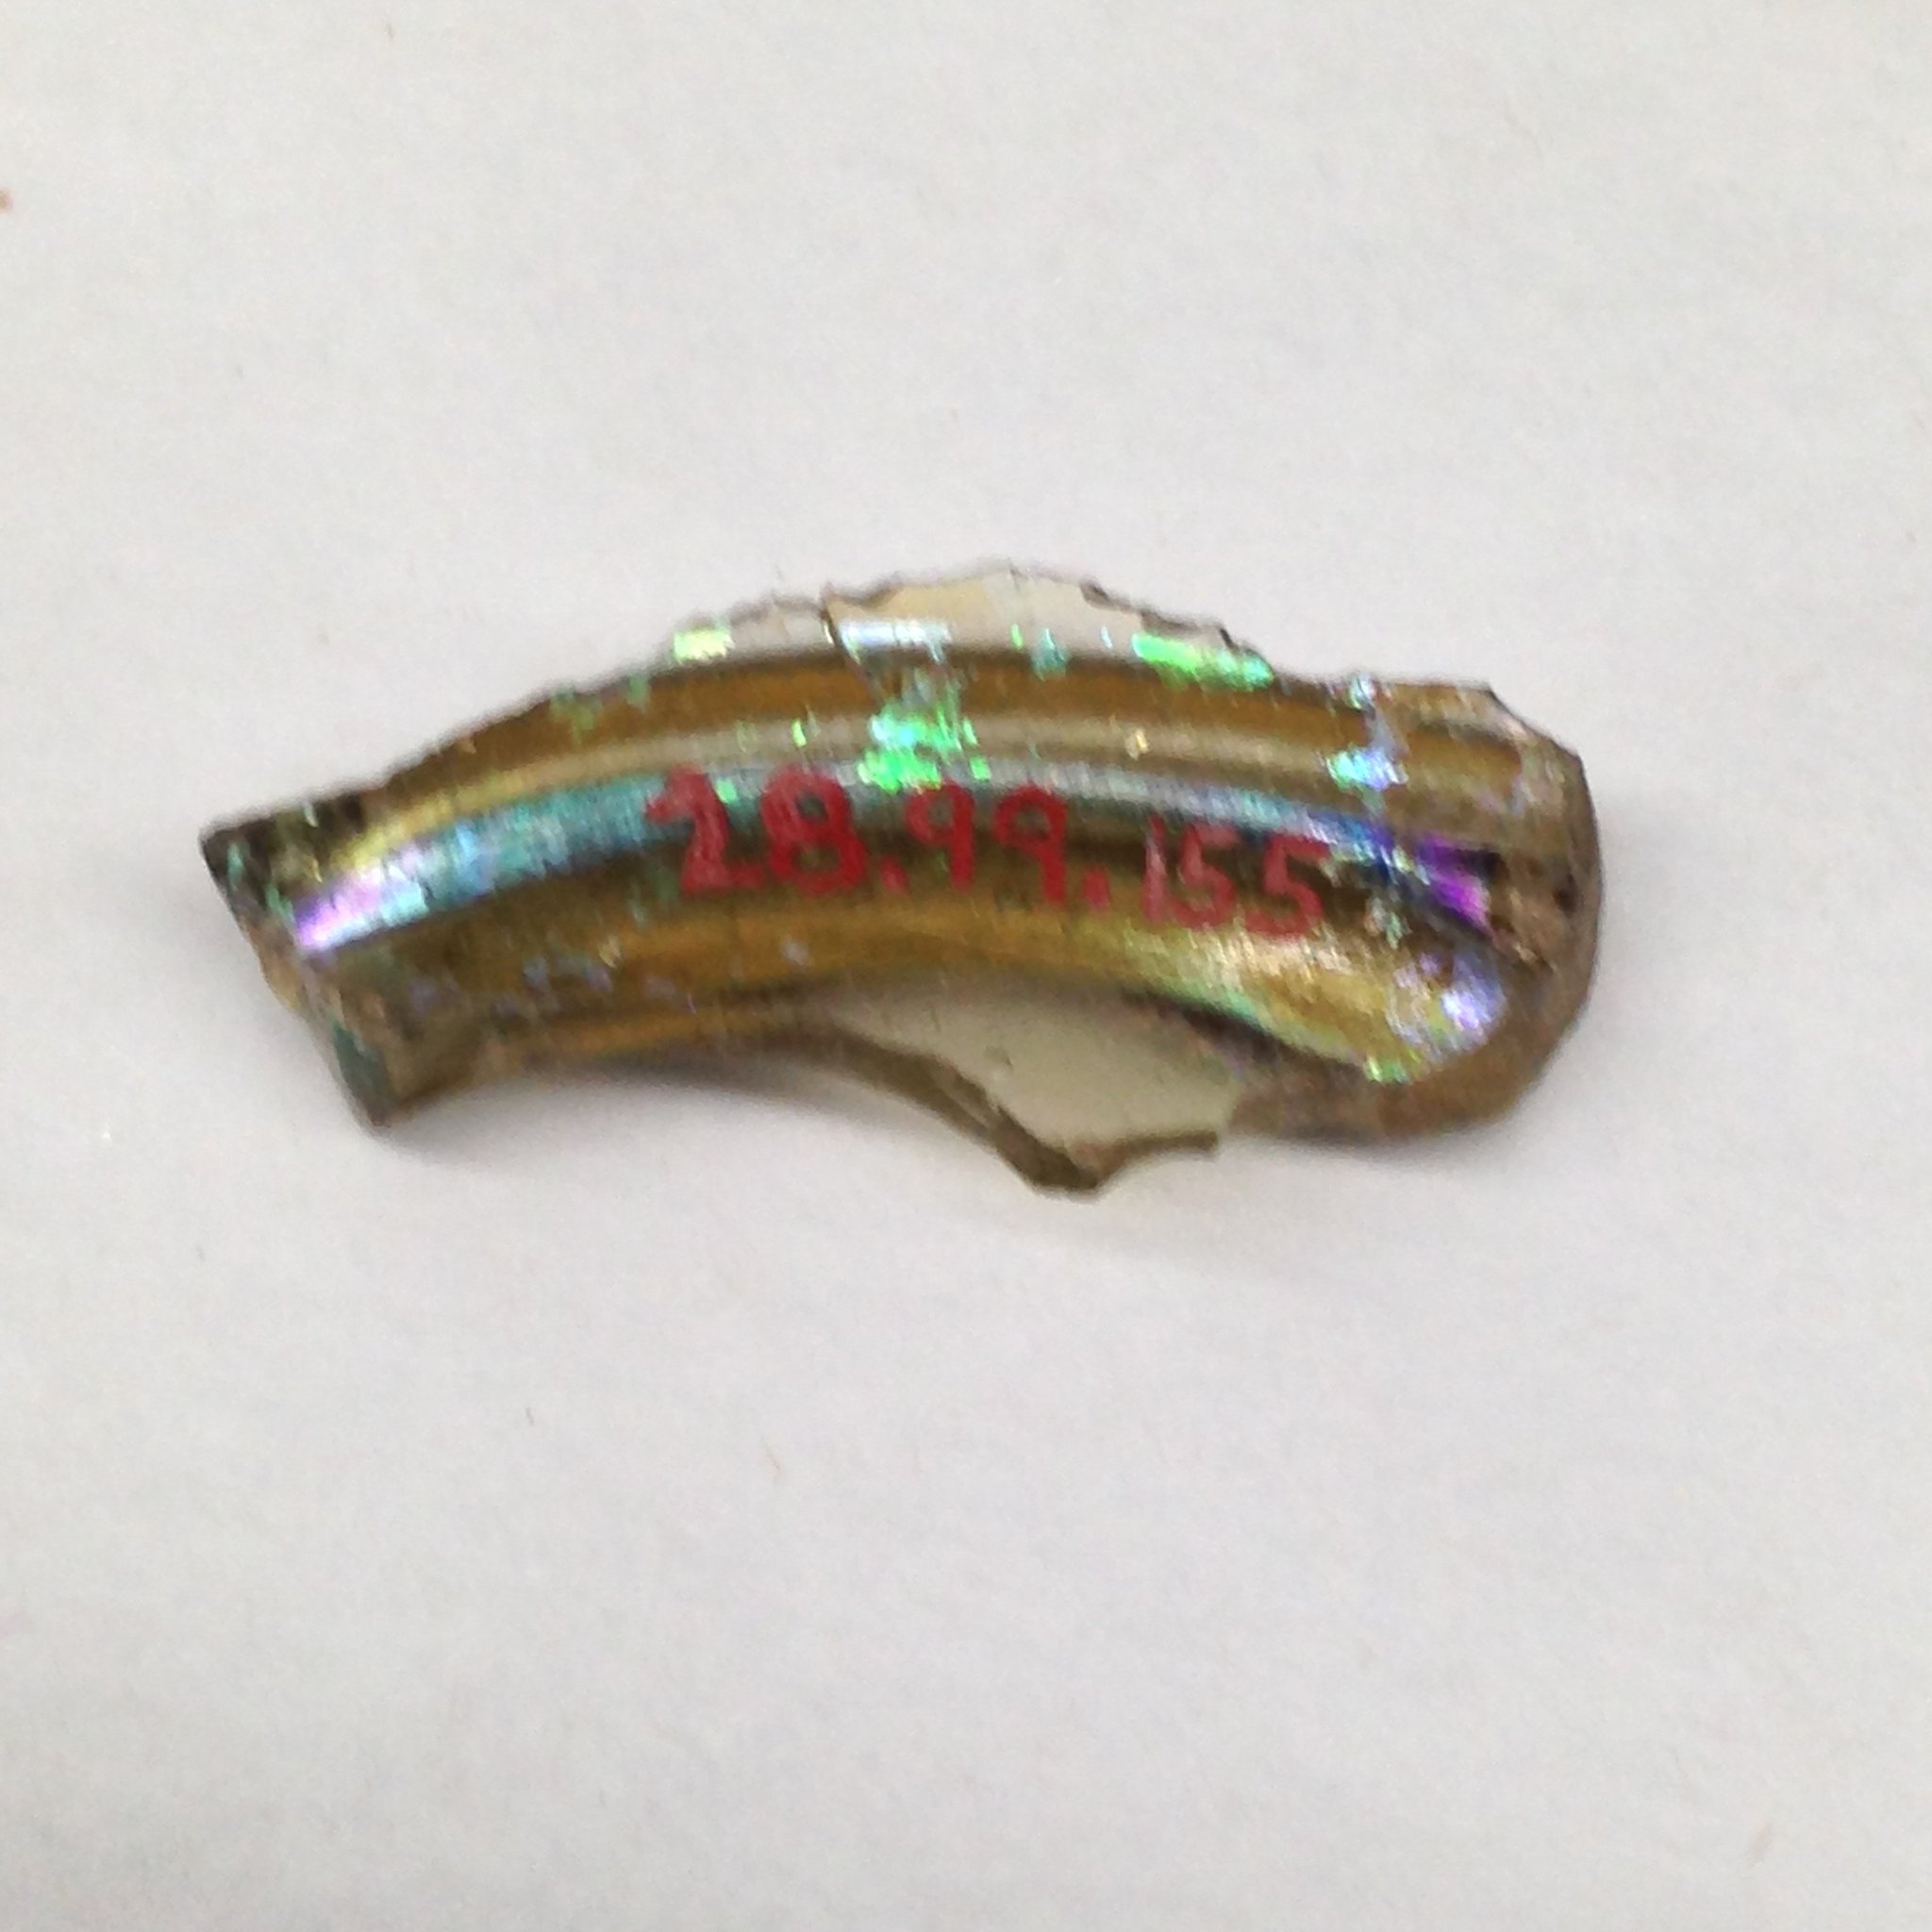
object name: fragment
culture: european or middle eastern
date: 1150-1250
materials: ceramic, glass